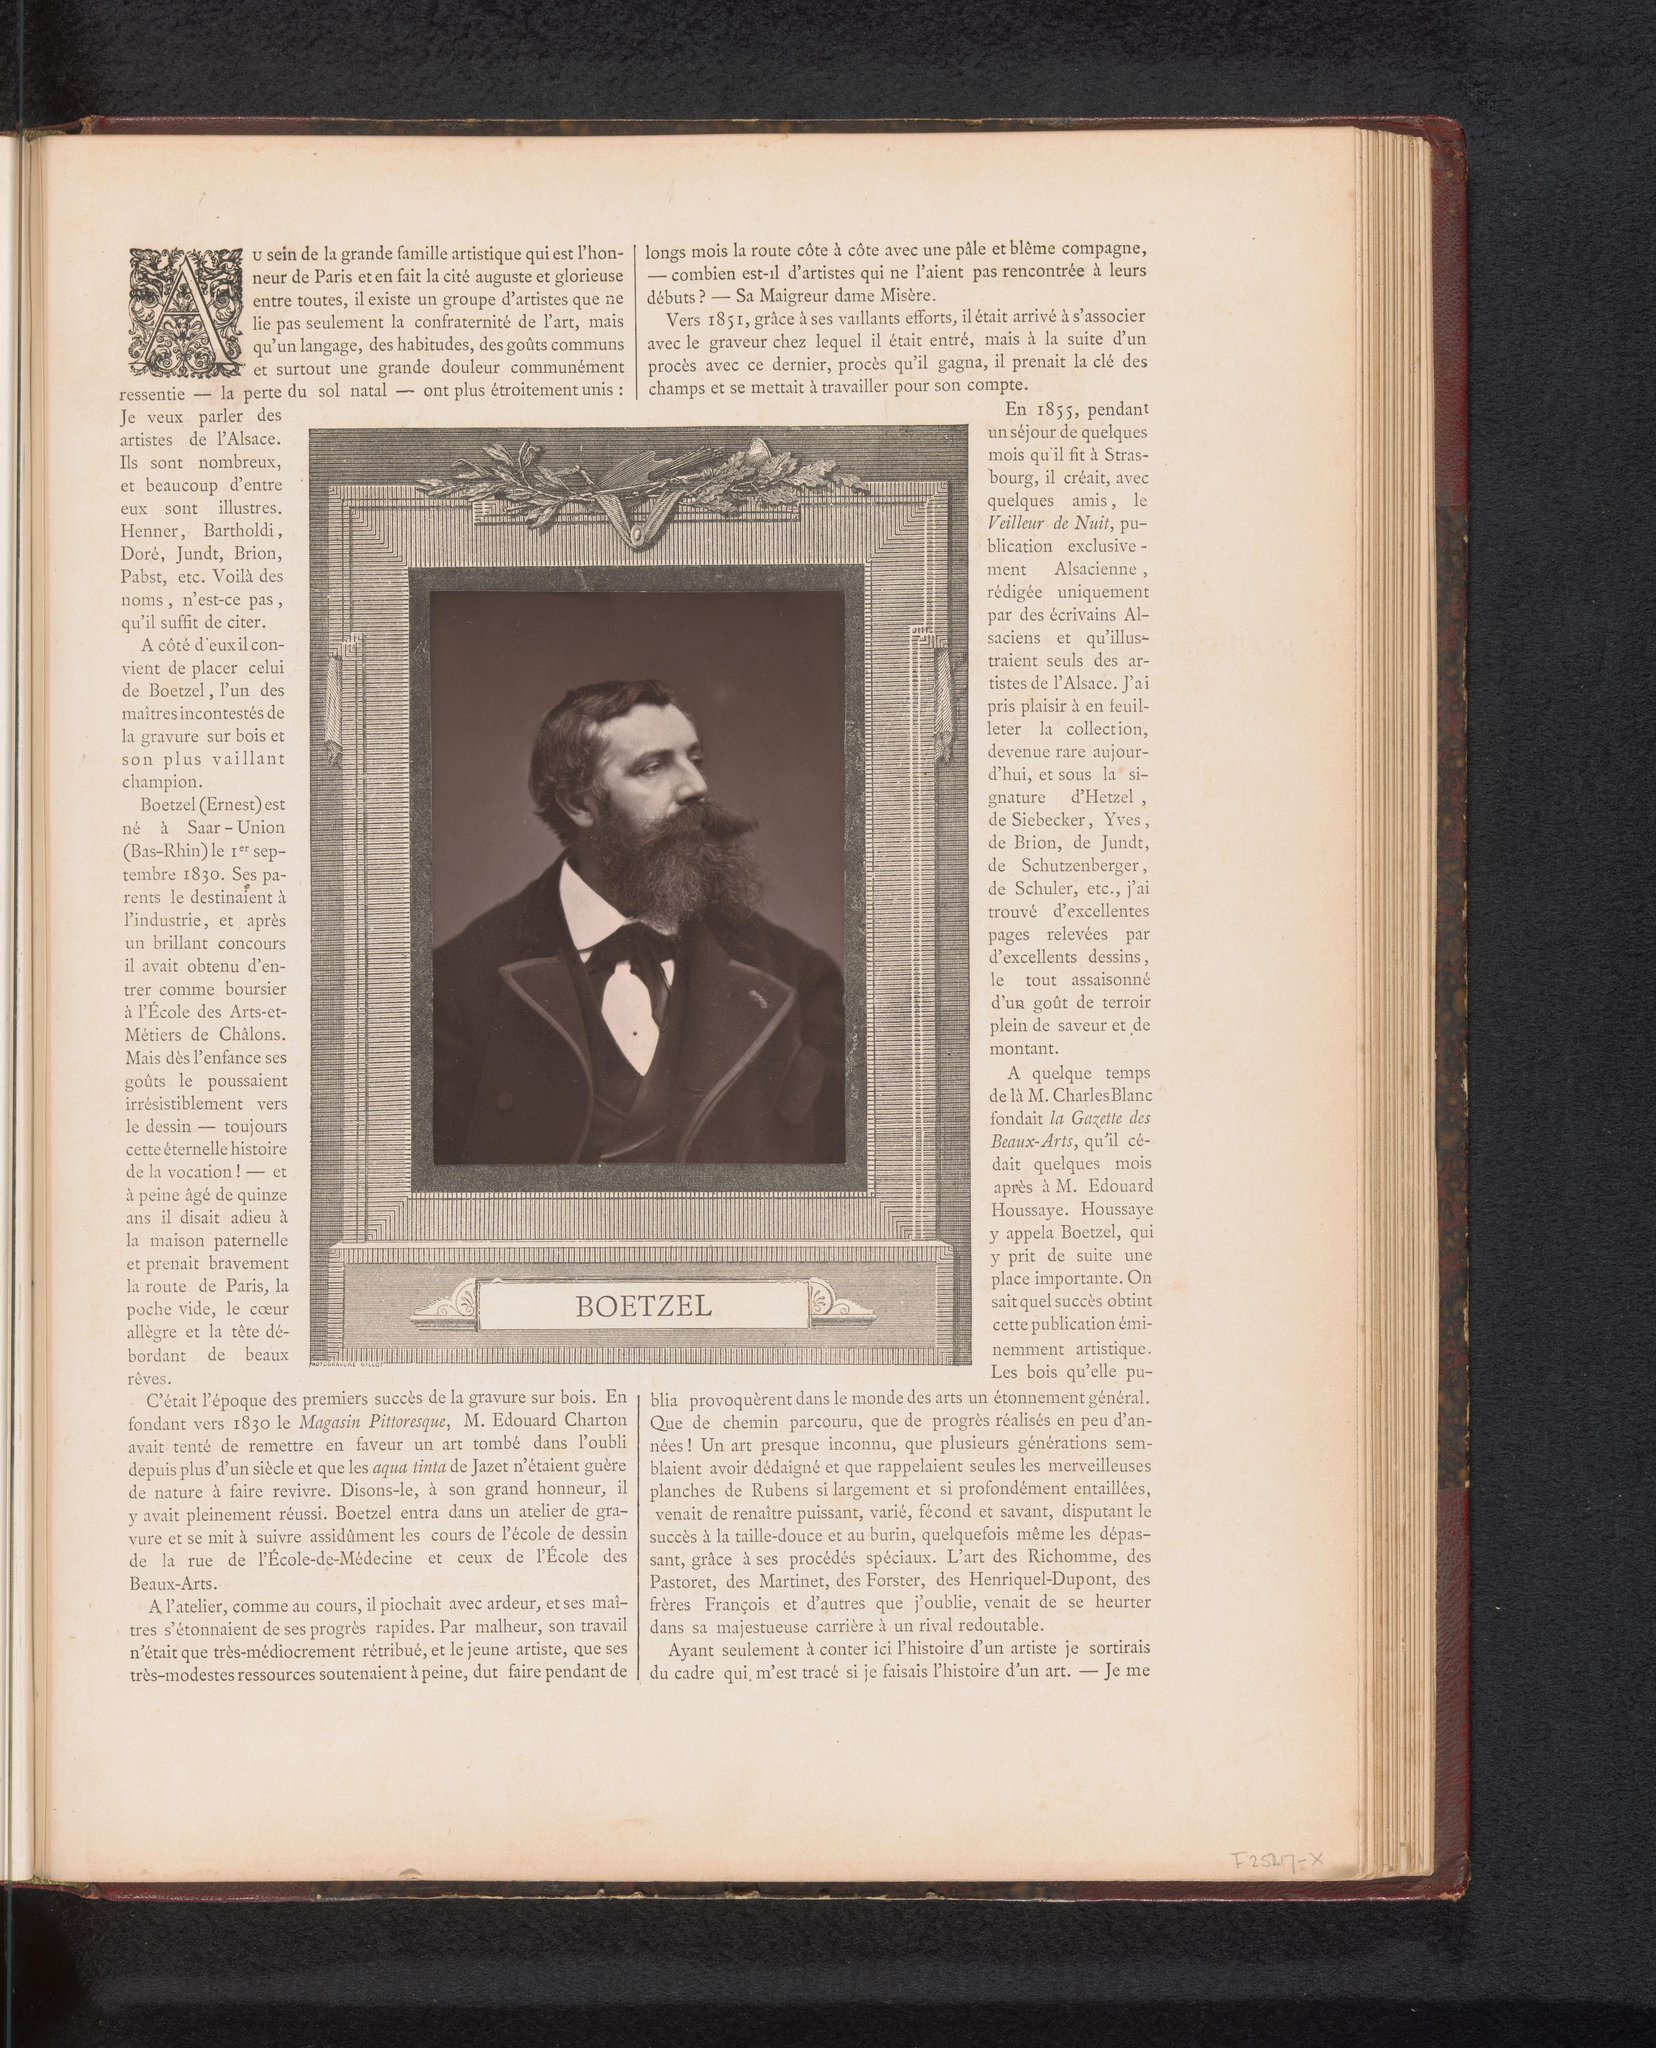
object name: page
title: Boetzel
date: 1872-1877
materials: paper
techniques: printing block, woodburytype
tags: ernest boetzel, adult man, historical persons